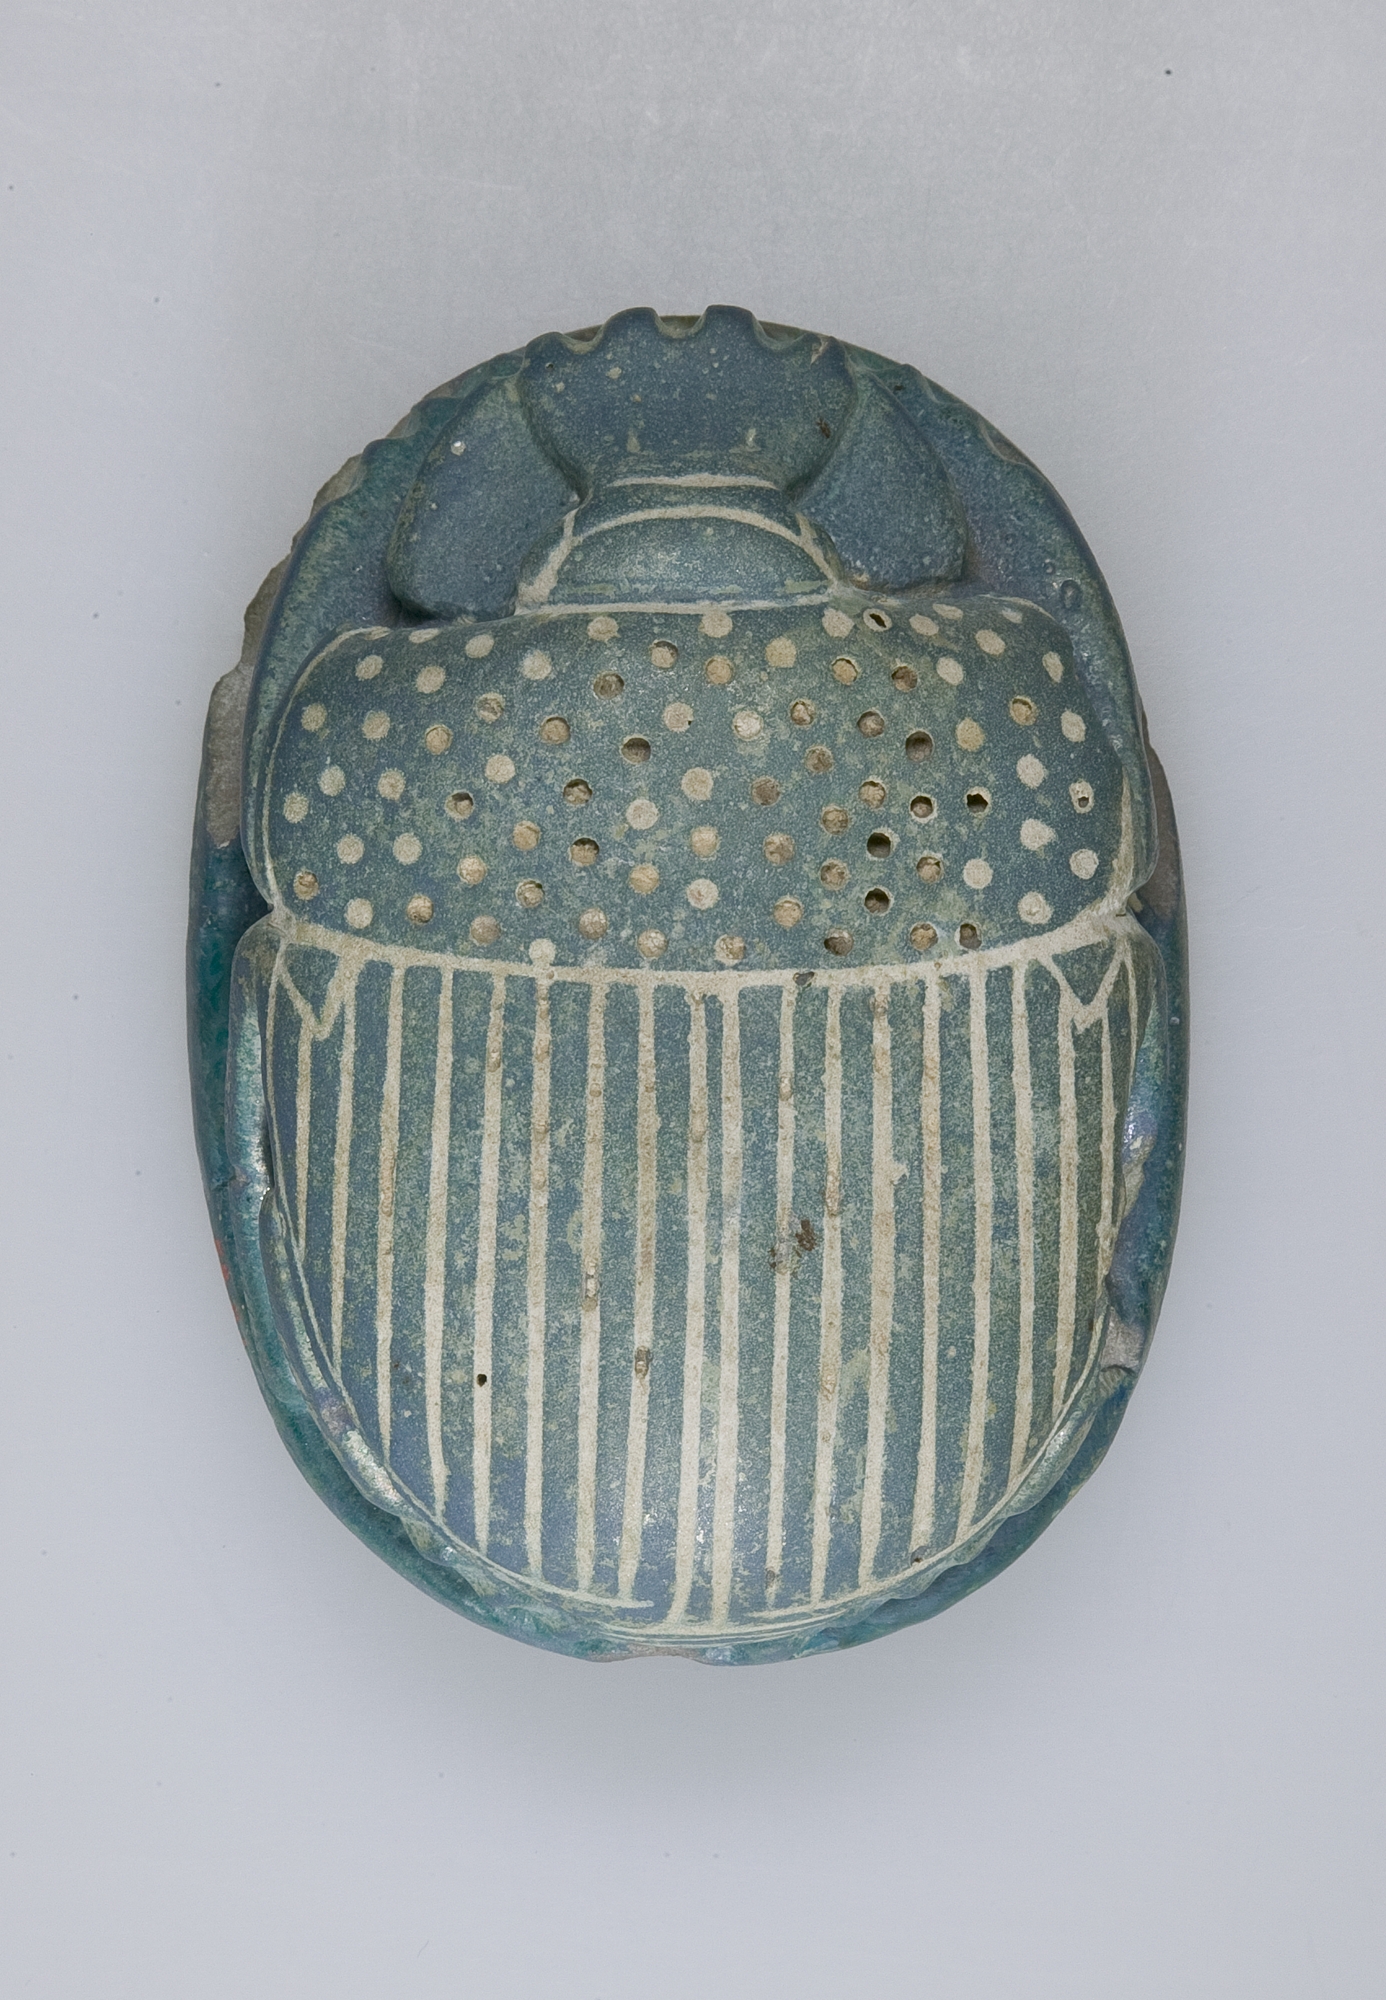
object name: scarab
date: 1295-1070 BCE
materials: faience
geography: egypt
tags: hieroglyphs,scarabs